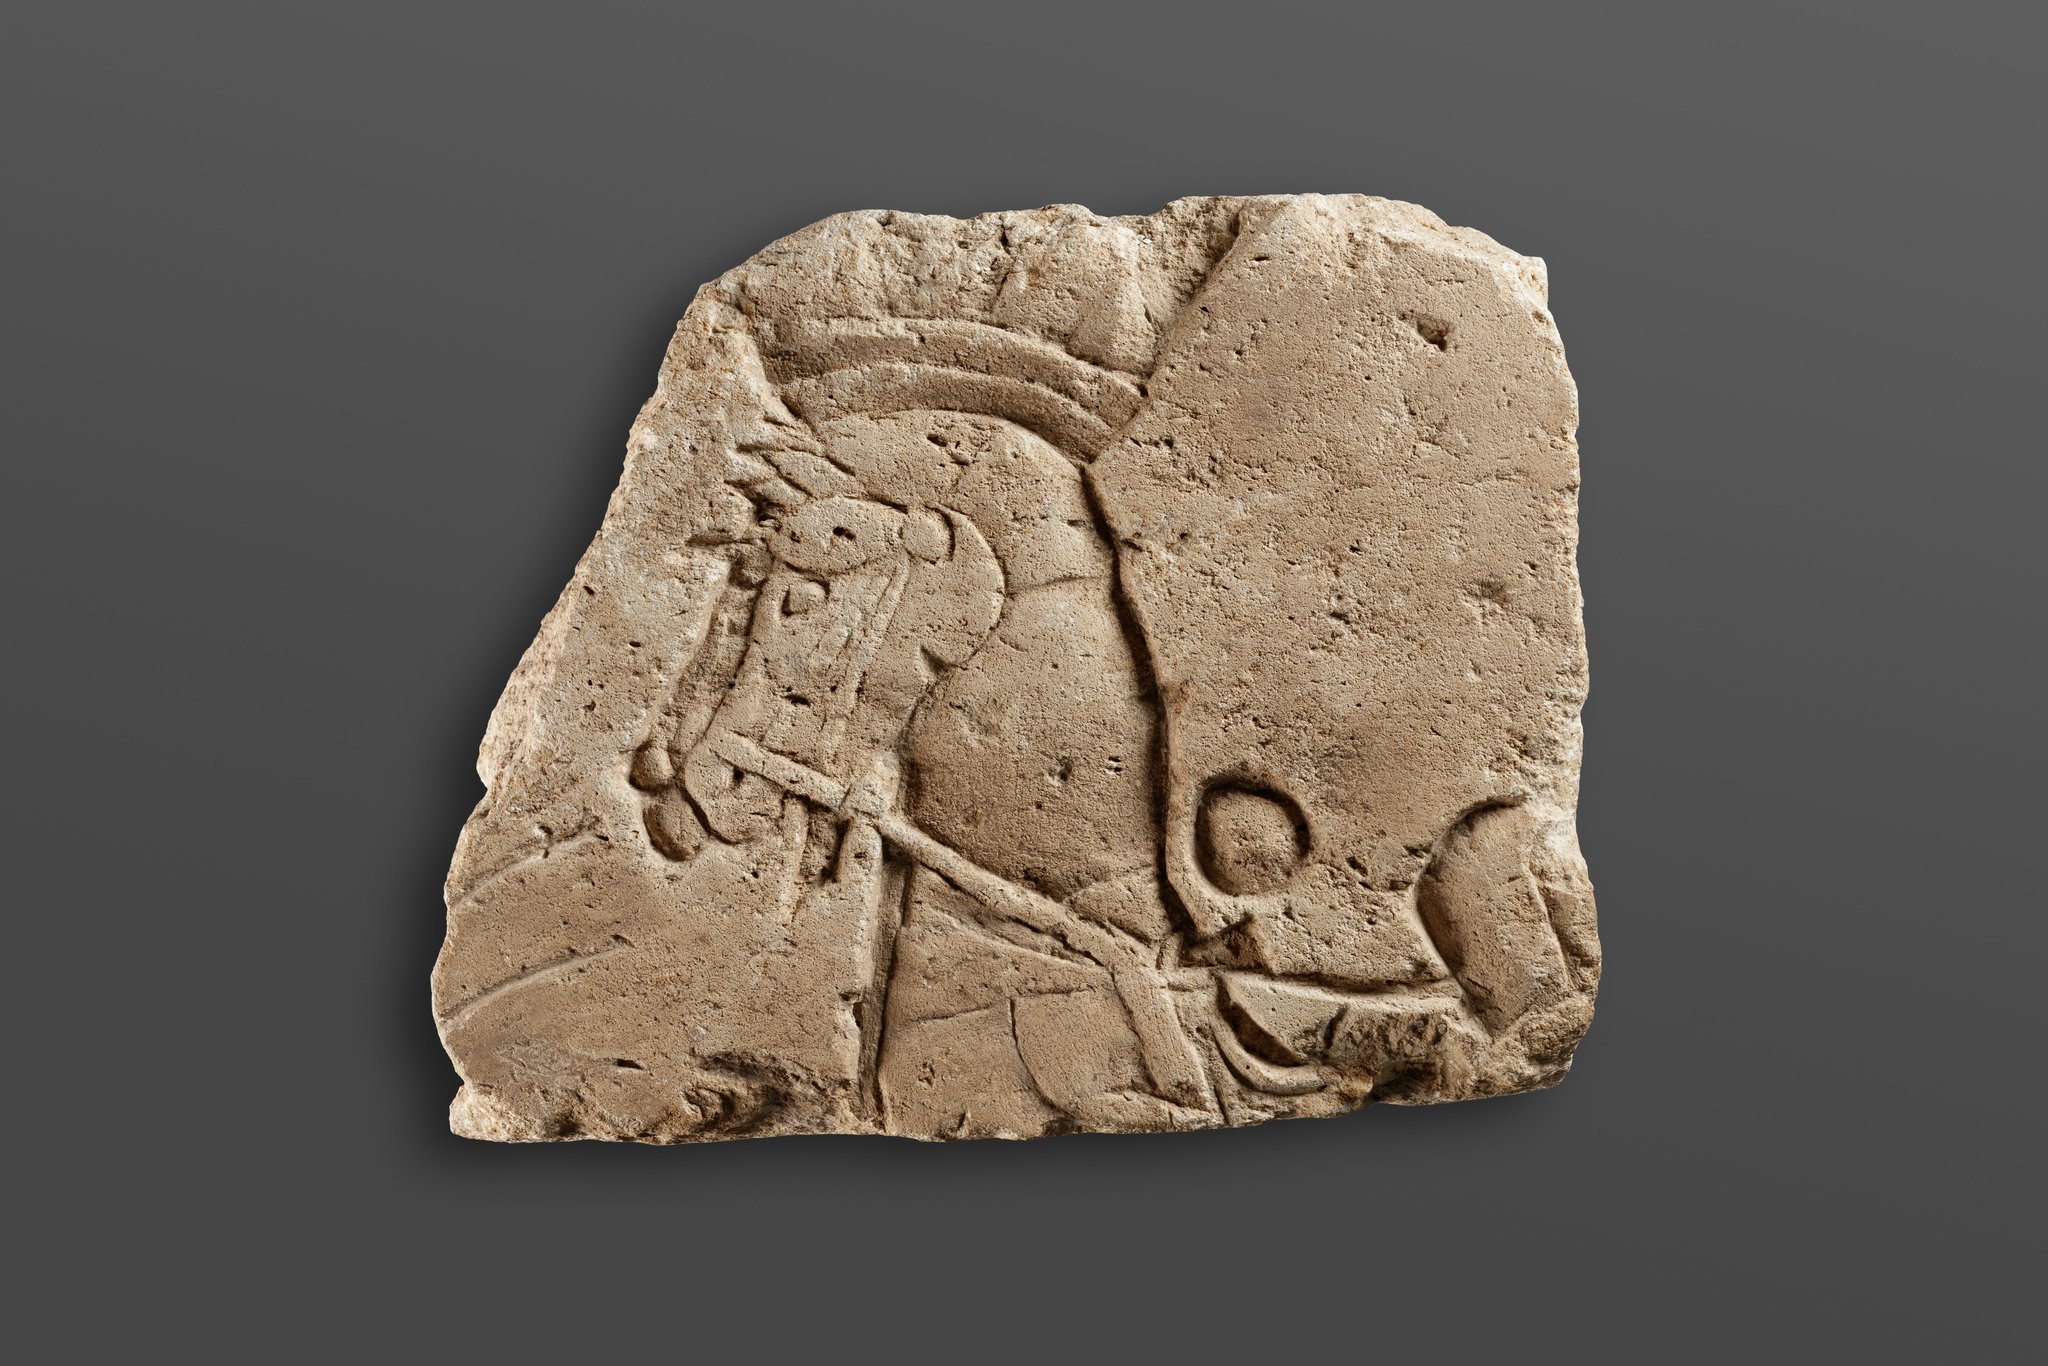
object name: relief, horse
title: Relief Depicting Heads and Chests of Two Horses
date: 1353-1336 BCE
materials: limestone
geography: egypt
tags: horses